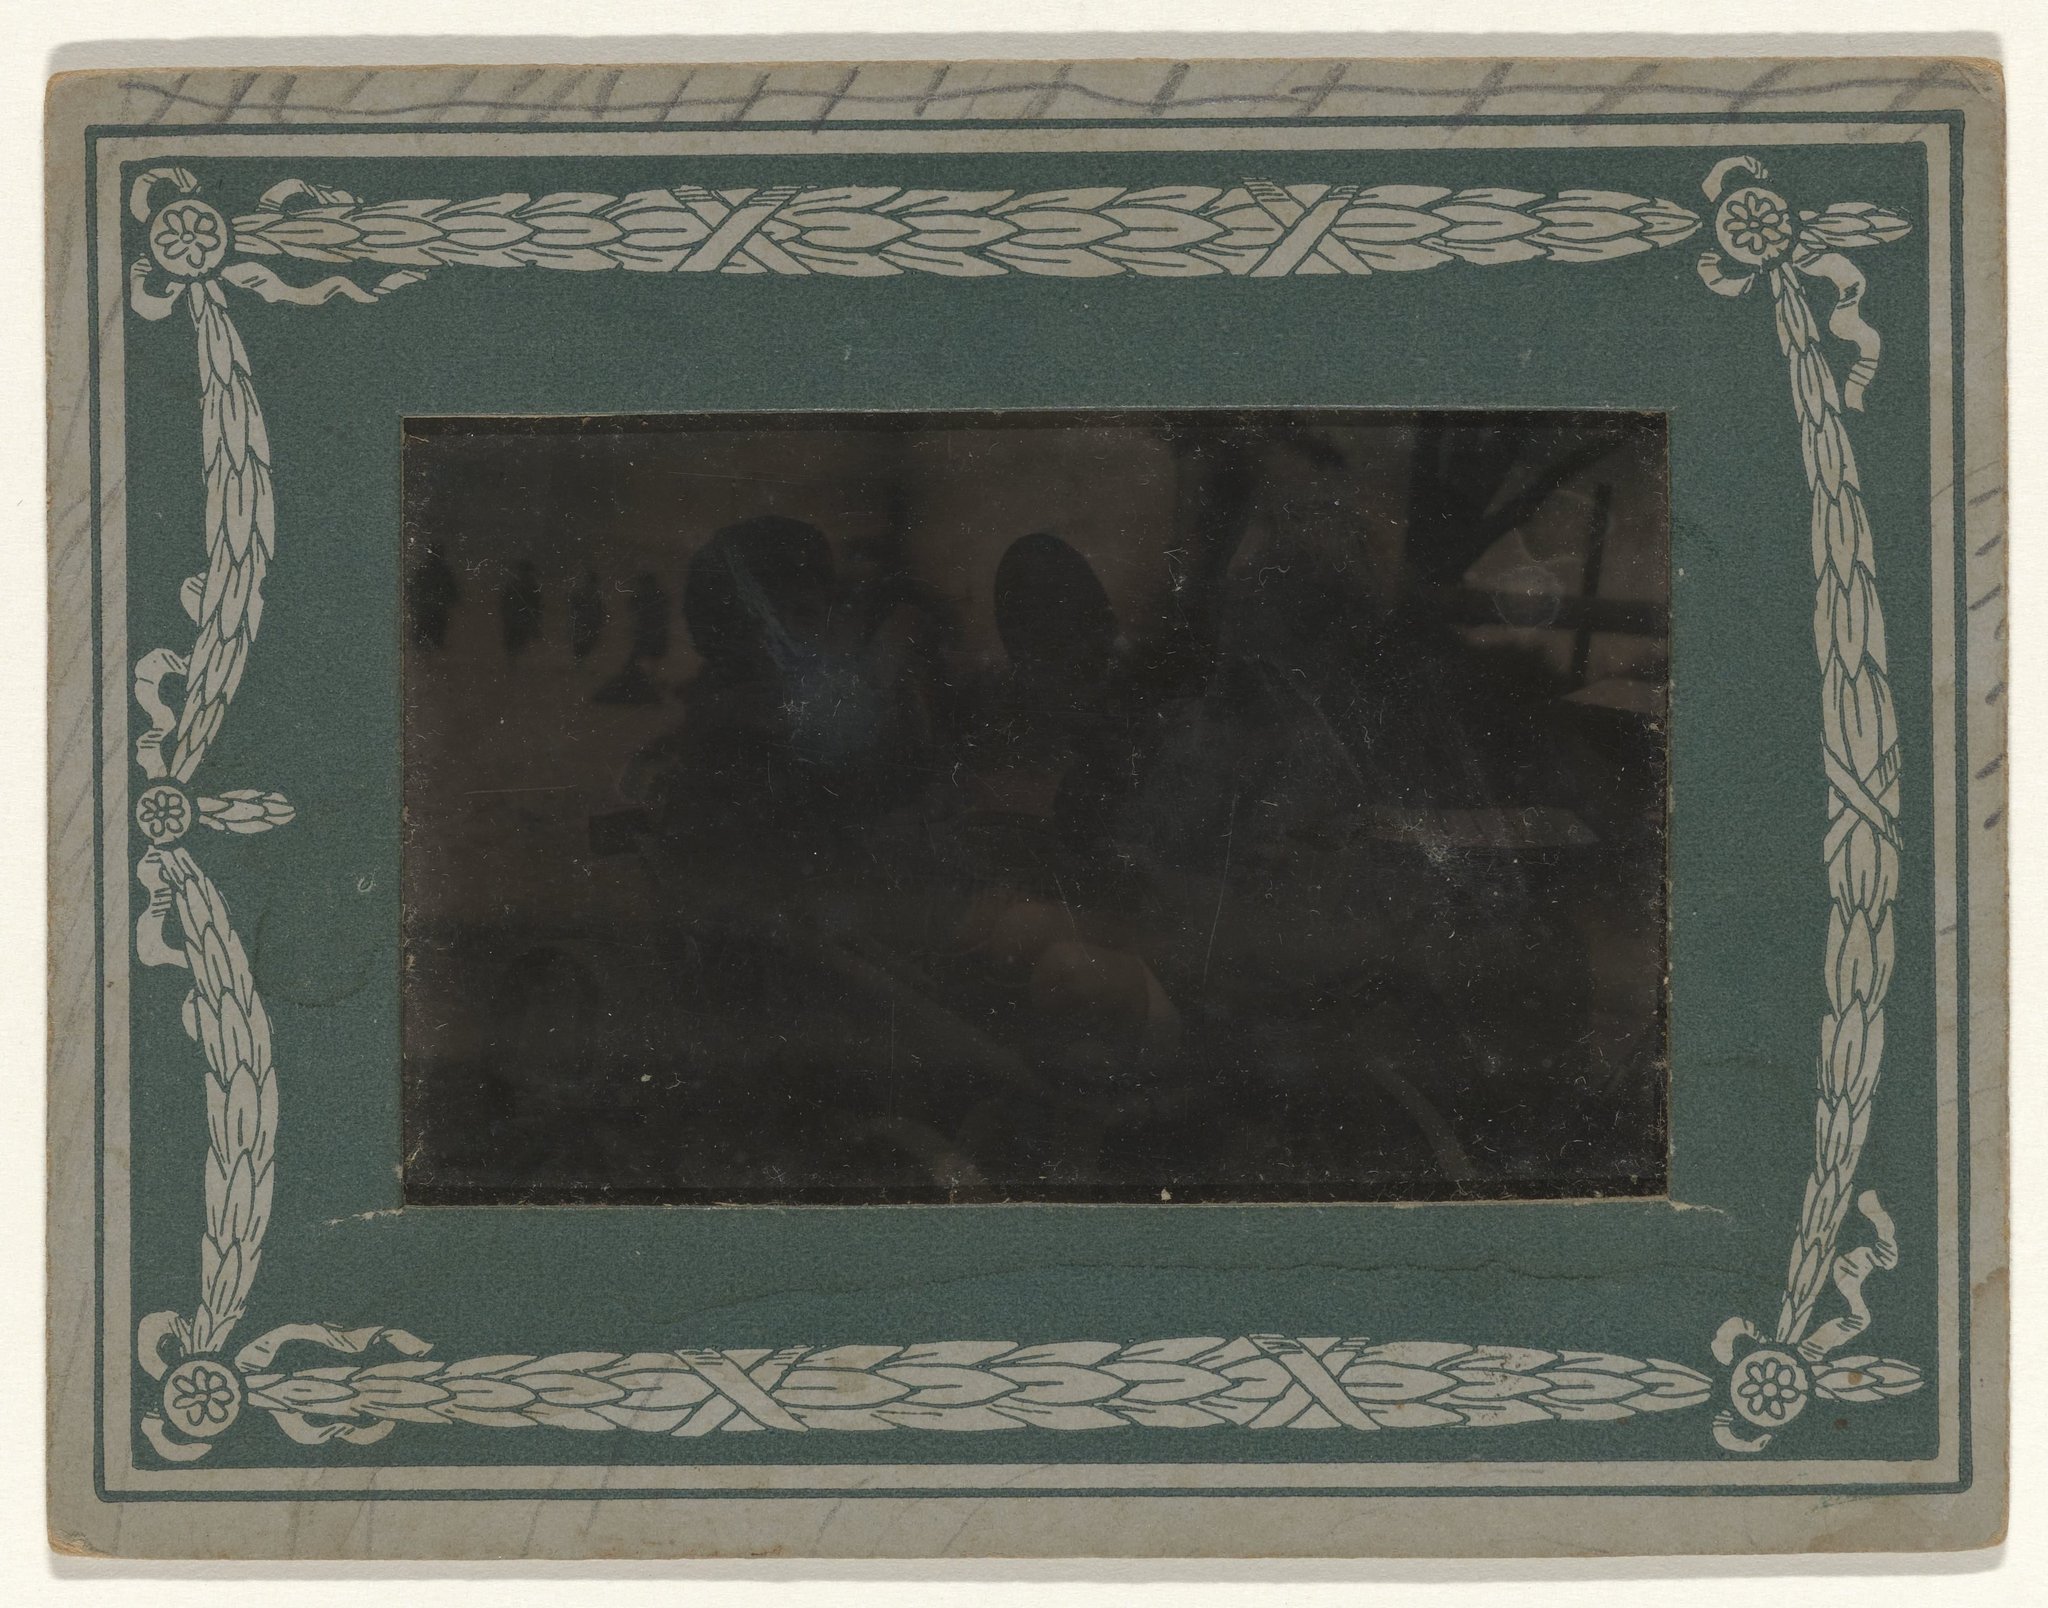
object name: photograph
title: Kinderen in een kar, waarschijnlijk op het strand van Valkeveen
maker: Anonymous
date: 1915-1925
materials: cardboard, iron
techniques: ferrotyping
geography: valkeveen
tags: hand-cart, child